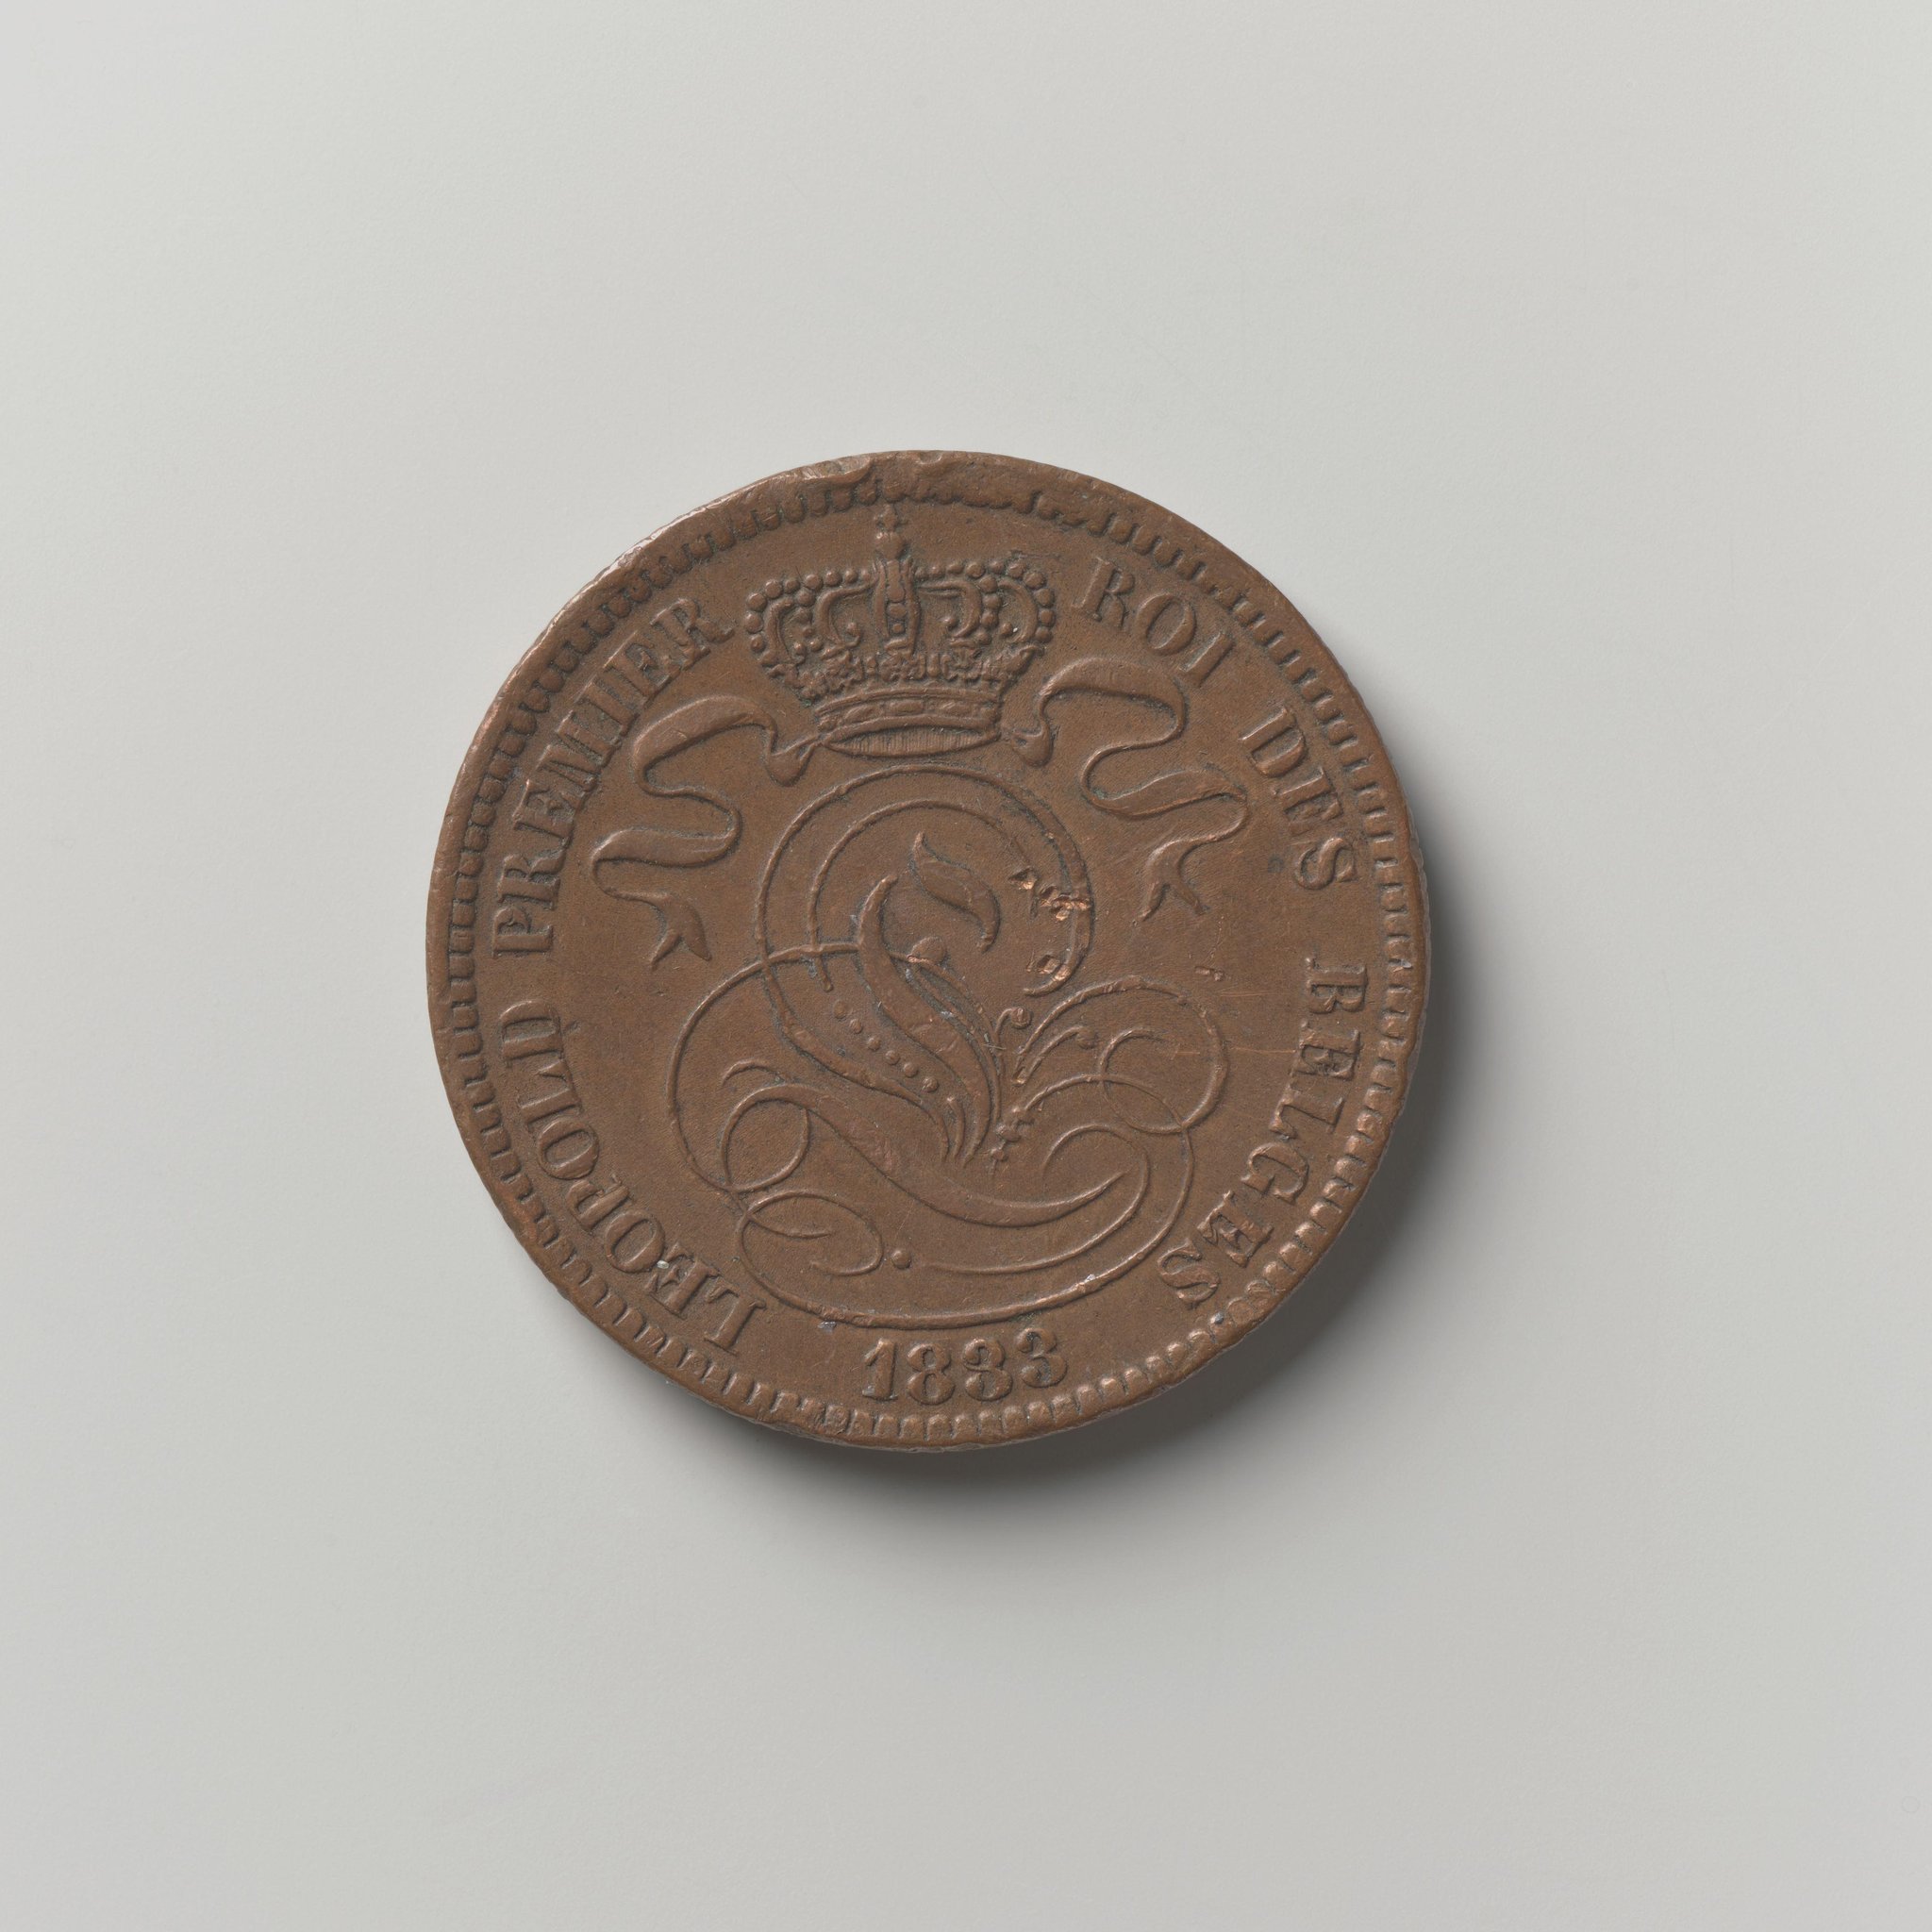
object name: coin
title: België, Leopold I, 10 centimes, 1833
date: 1833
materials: copper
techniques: striking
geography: brussels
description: Koperen munt. Voorzijde: zittende, omkijkende leeuw naar links met onder rechter klauw paneel met opschrift. In afsnede waarde-aanduiding. Keerzijde: gekroond monogram. Jaartal onderaan. Kartelrand.